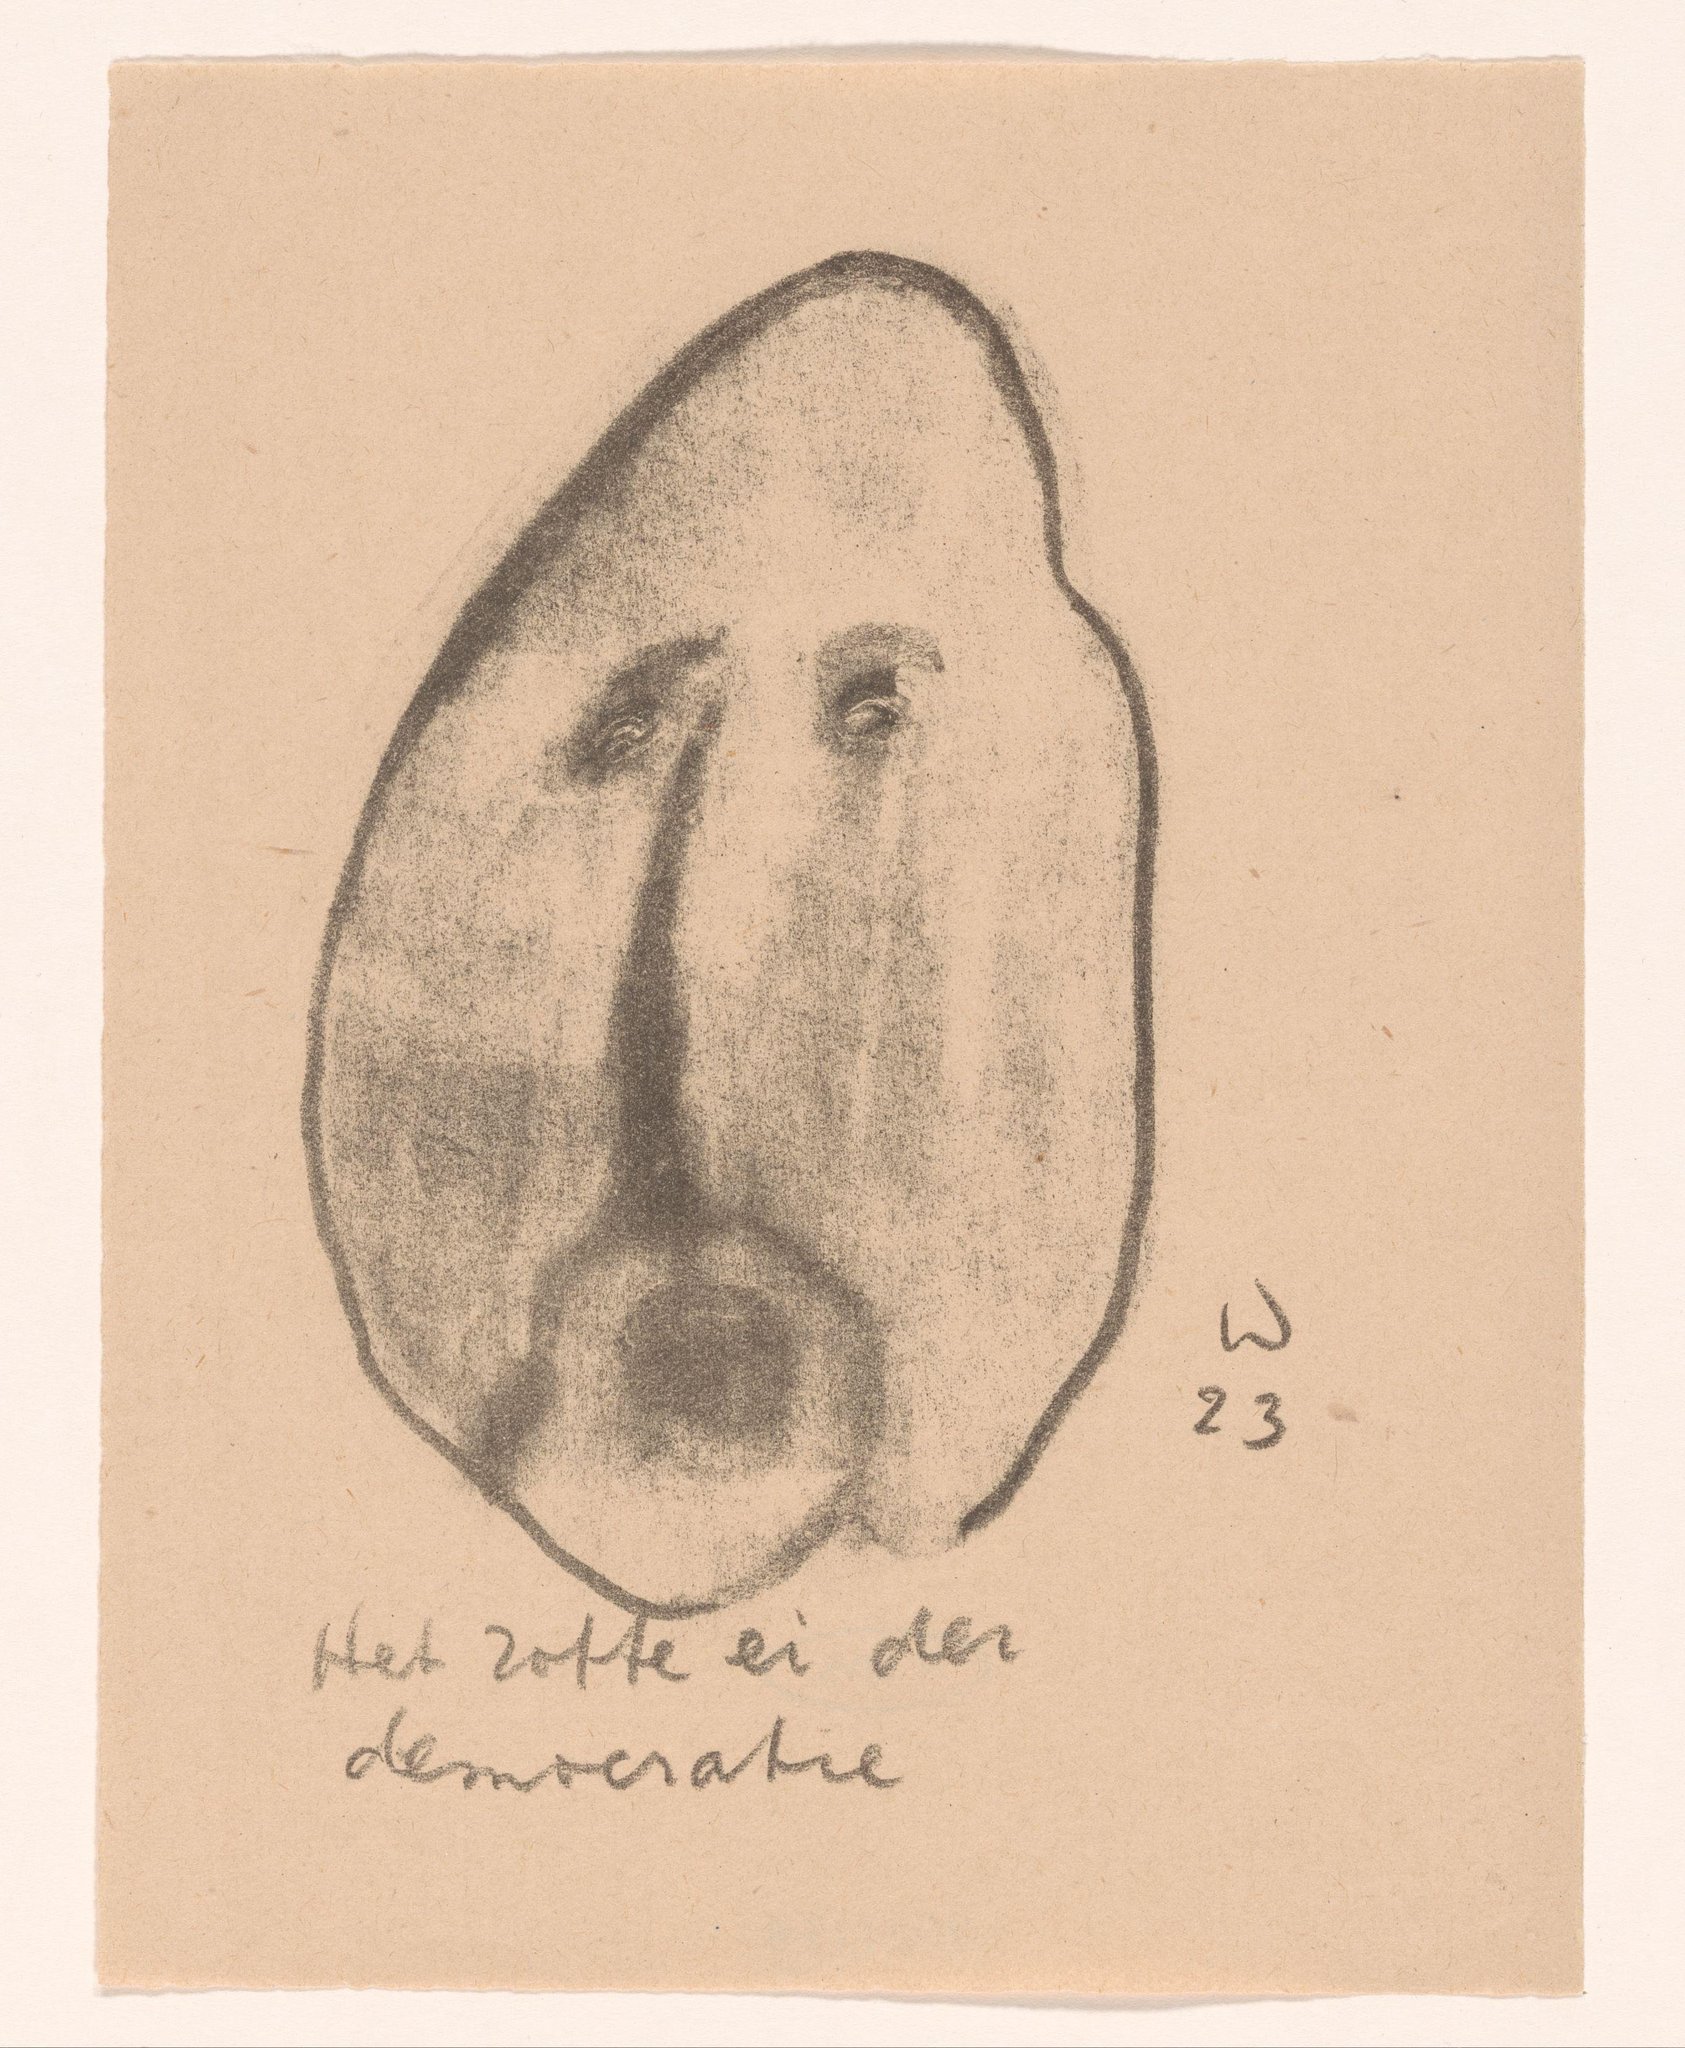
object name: print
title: Idealisten II en verdere Kanttekeningen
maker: erich wichmann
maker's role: print maker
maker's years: 1890-1929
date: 1923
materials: paper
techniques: lithograph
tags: caricatures (human types), democracy; 'democratia' (ripa)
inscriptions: collector's mark: Lugt 2228